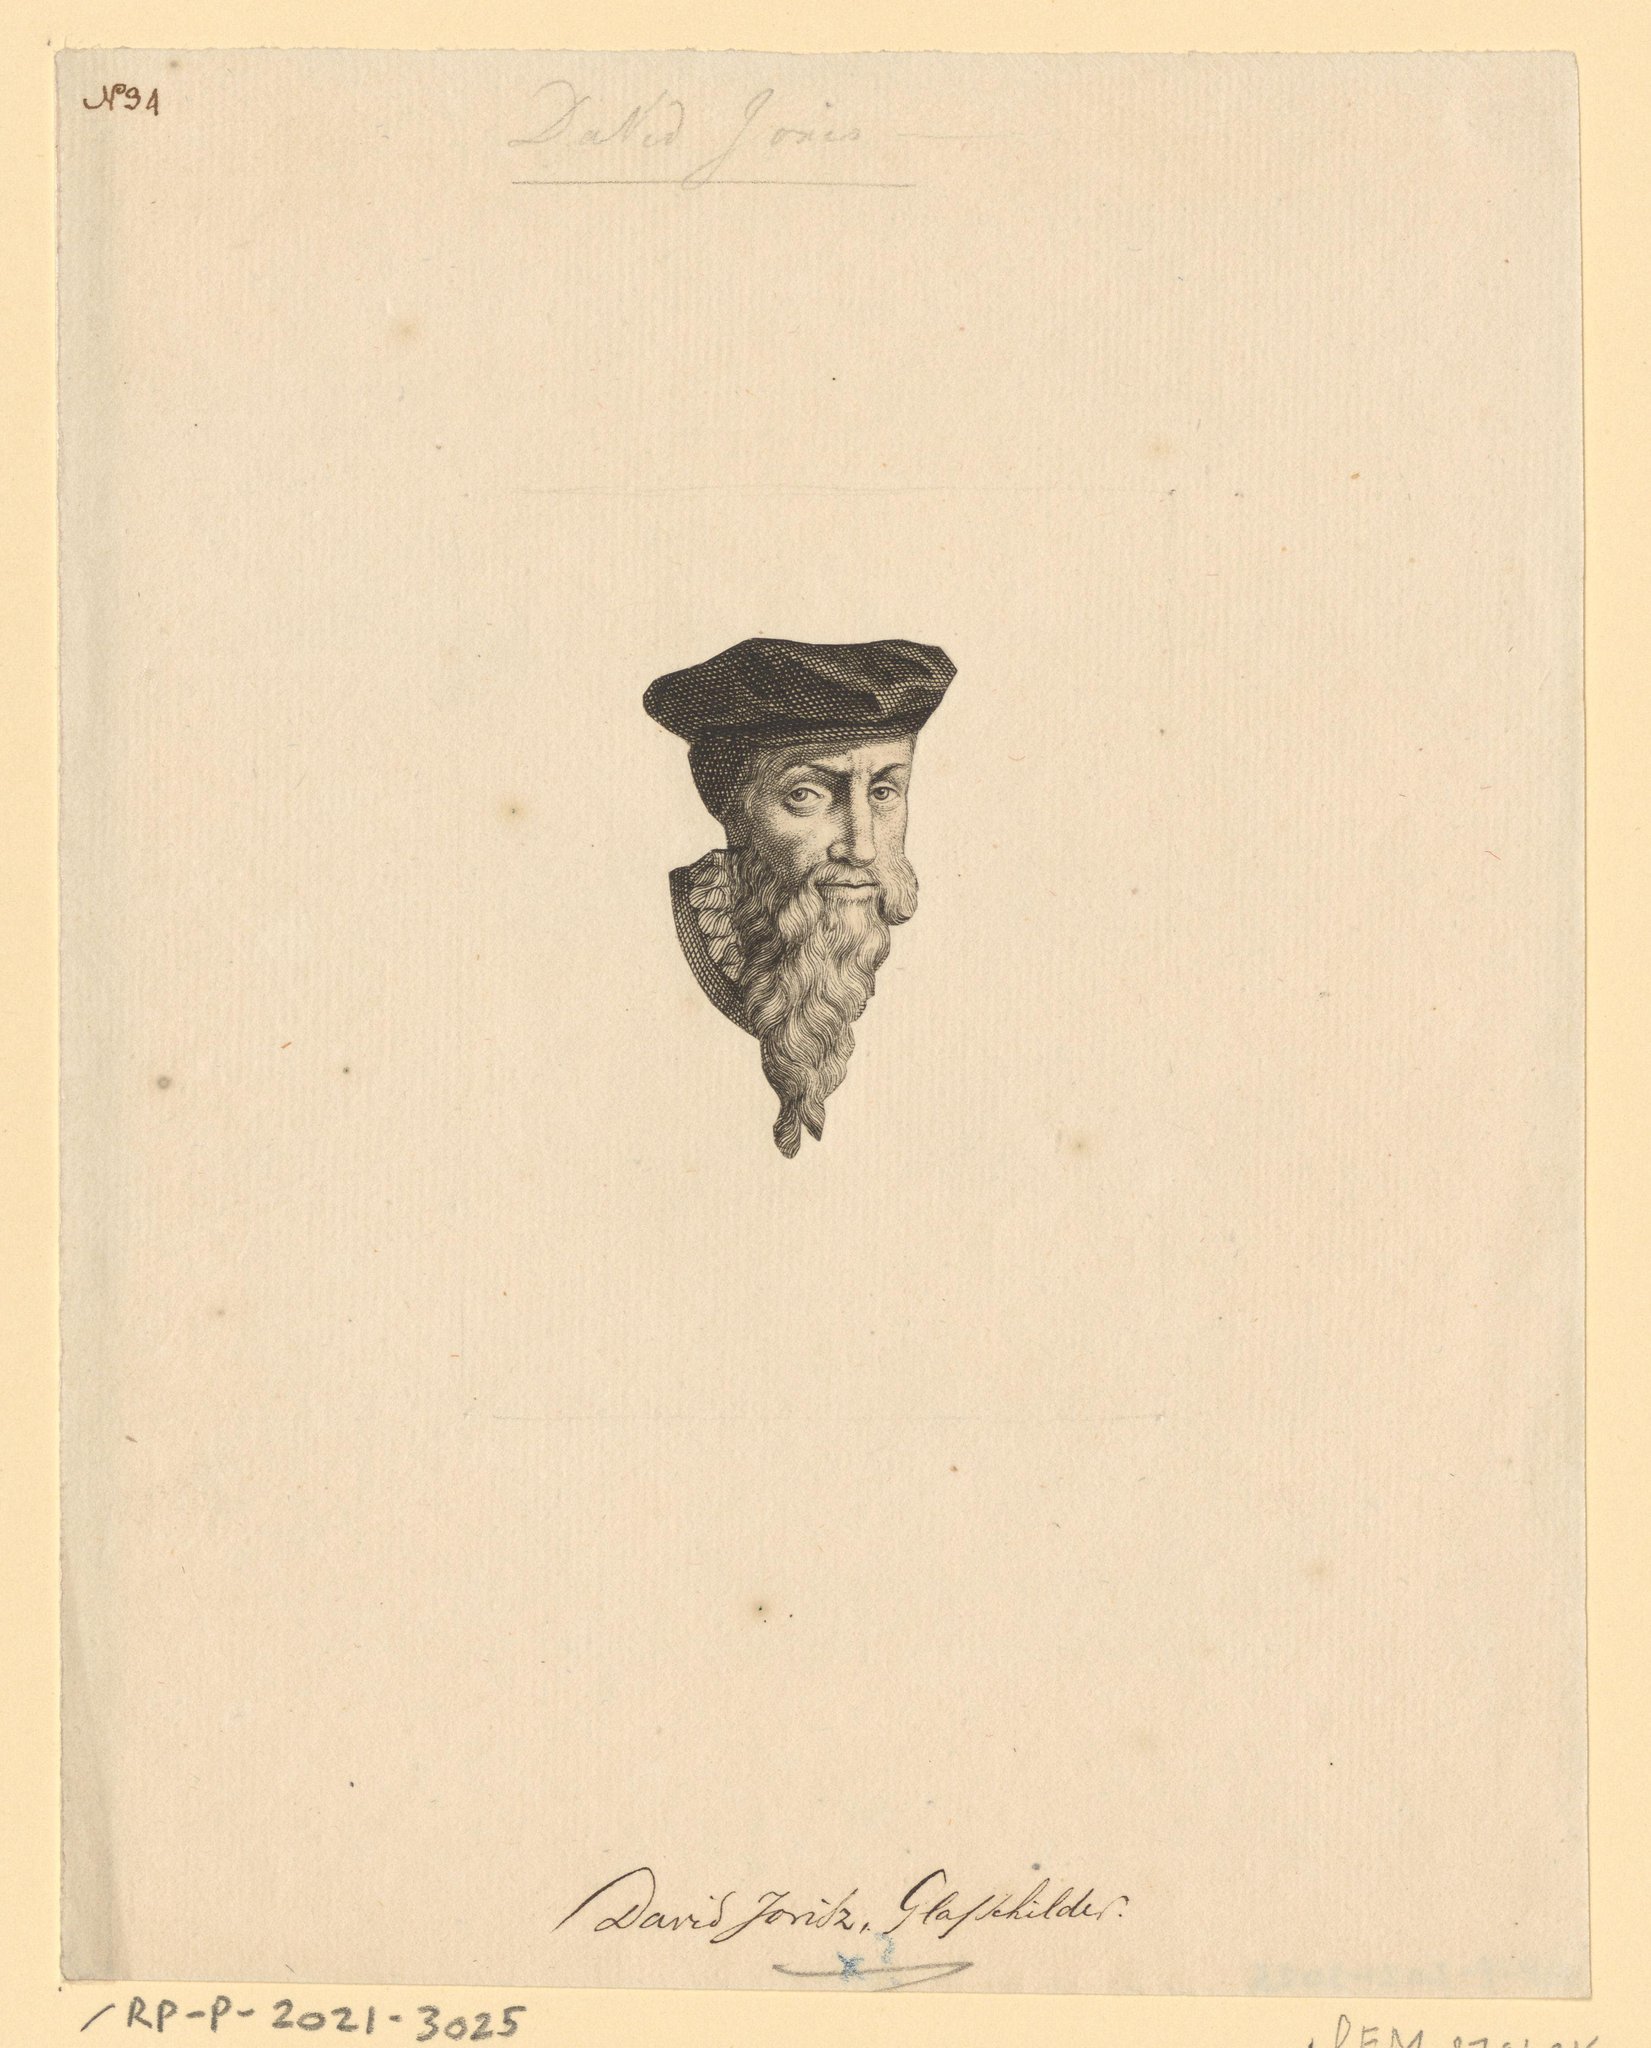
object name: print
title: Portret van David Jorisz.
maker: jacob houbraken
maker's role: draughtsman, print maker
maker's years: 1698-1780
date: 1729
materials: paper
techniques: engraving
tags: bruges, david jorisz., historical persons, merchant, salesman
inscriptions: inscription: ‘David Jorisz, Glasschilder’, inscription: ‘No34’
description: Deze prent maakte deel uit van een grotere prent met drie portretten en een putto die later is verknipt. Prent mogelijk uit: Jacob Campo Weyerman. De levens-beschryvingen der Nederlandsche konst-schilders (...). Den Haag: weduwe Engelbrecht Boucquet, 1729, dl. 1, p. 195.